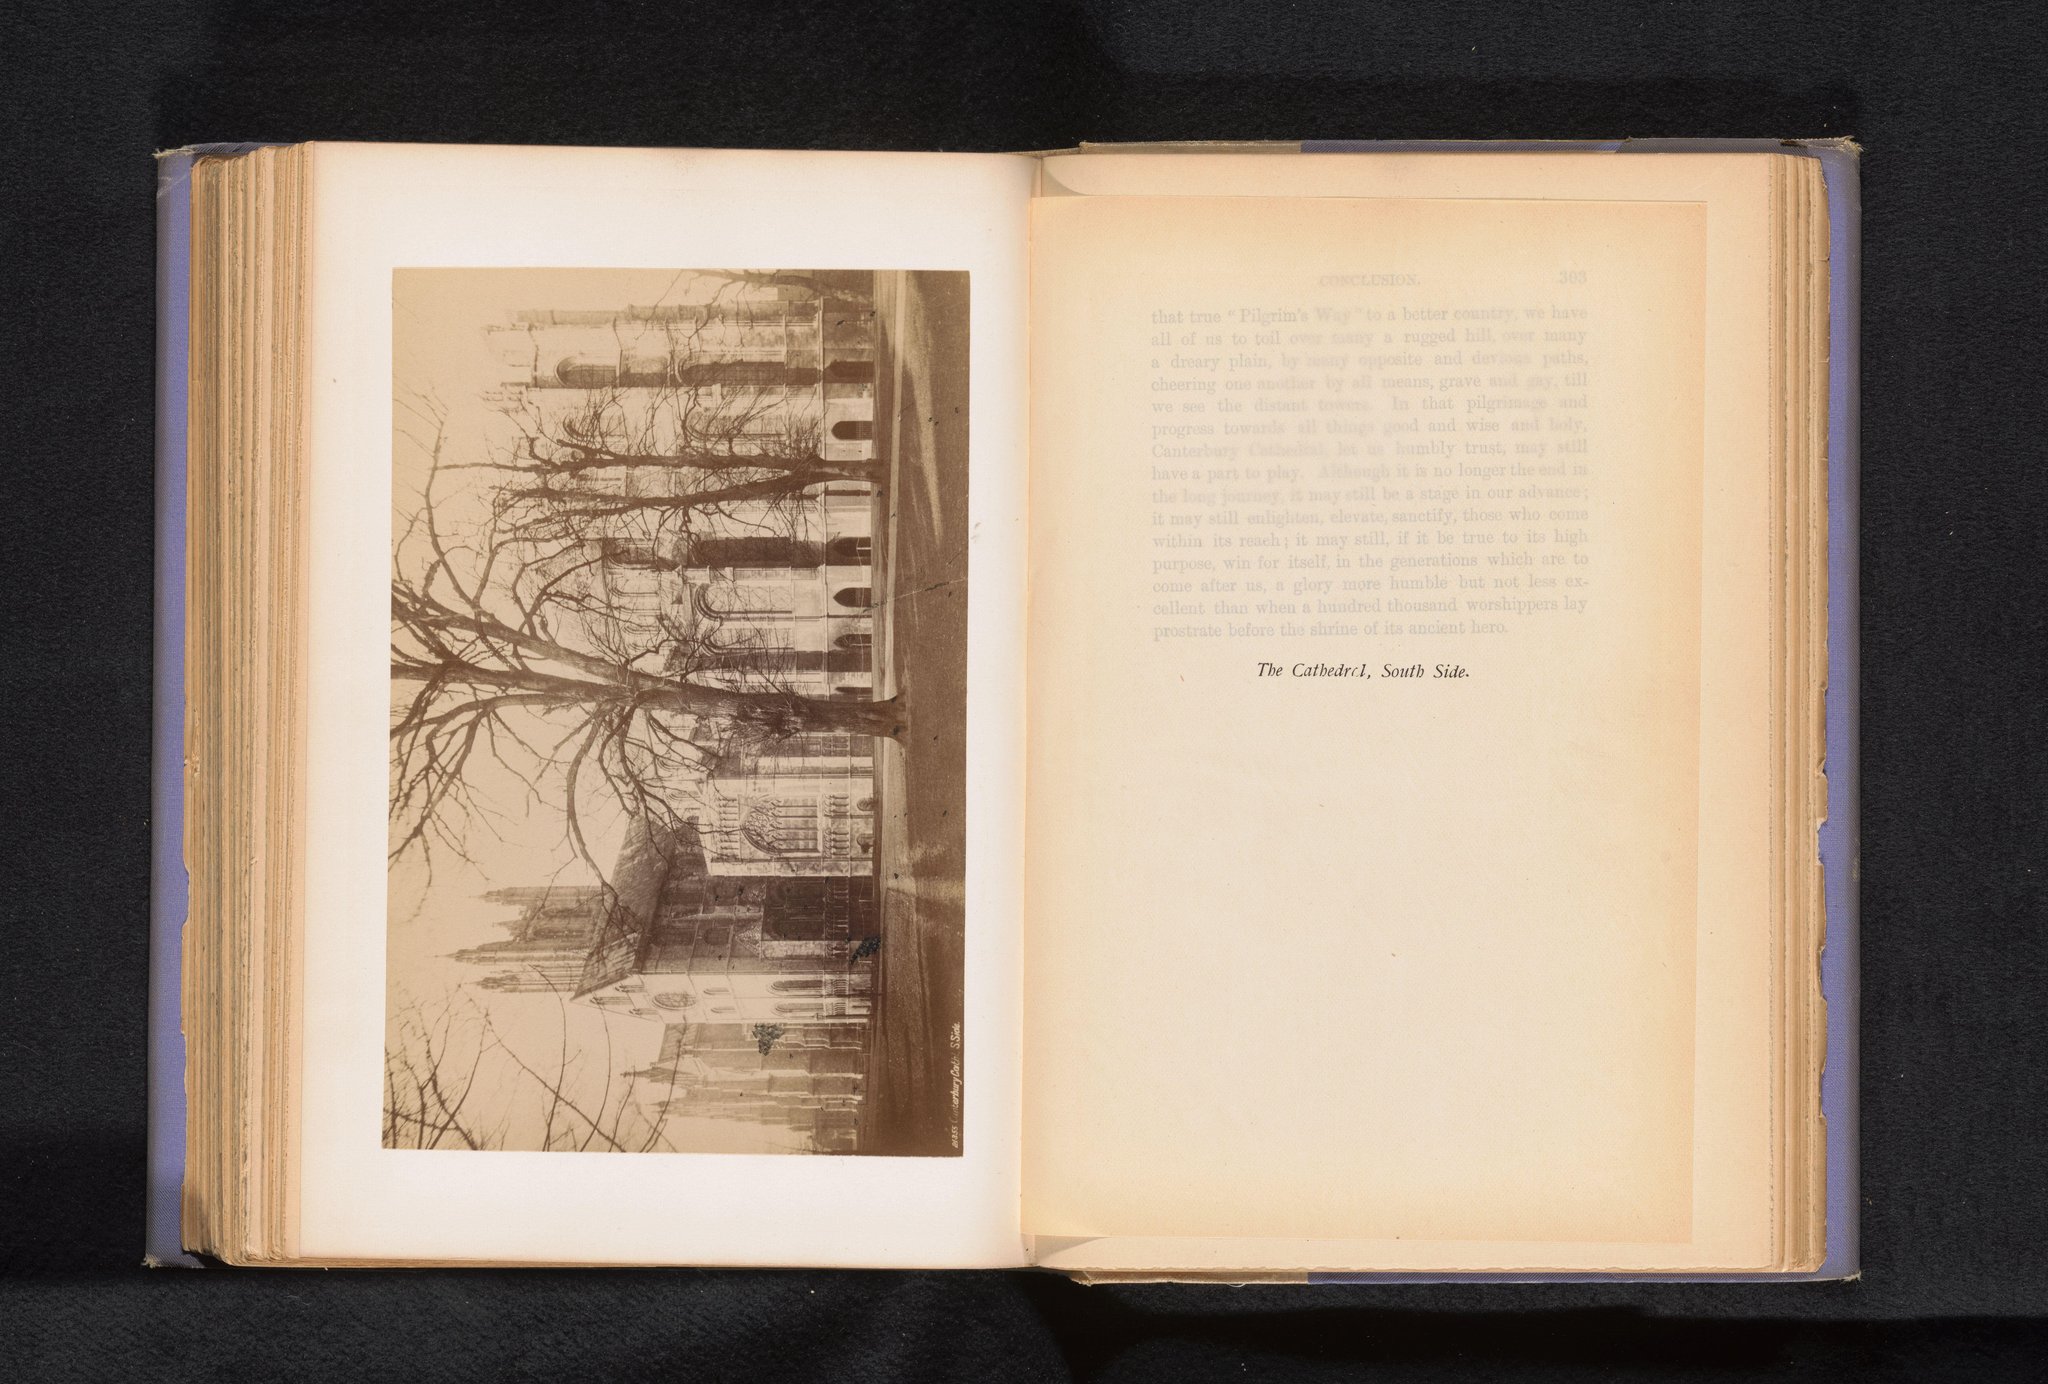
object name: photograph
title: The Cathedral, South Side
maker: Anonymous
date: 1882-1892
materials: photographic support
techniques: albumen print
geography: canterbury cathedral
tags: church (exterior)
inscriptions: number: ‘21355 Canterbury Cath. S.Side’